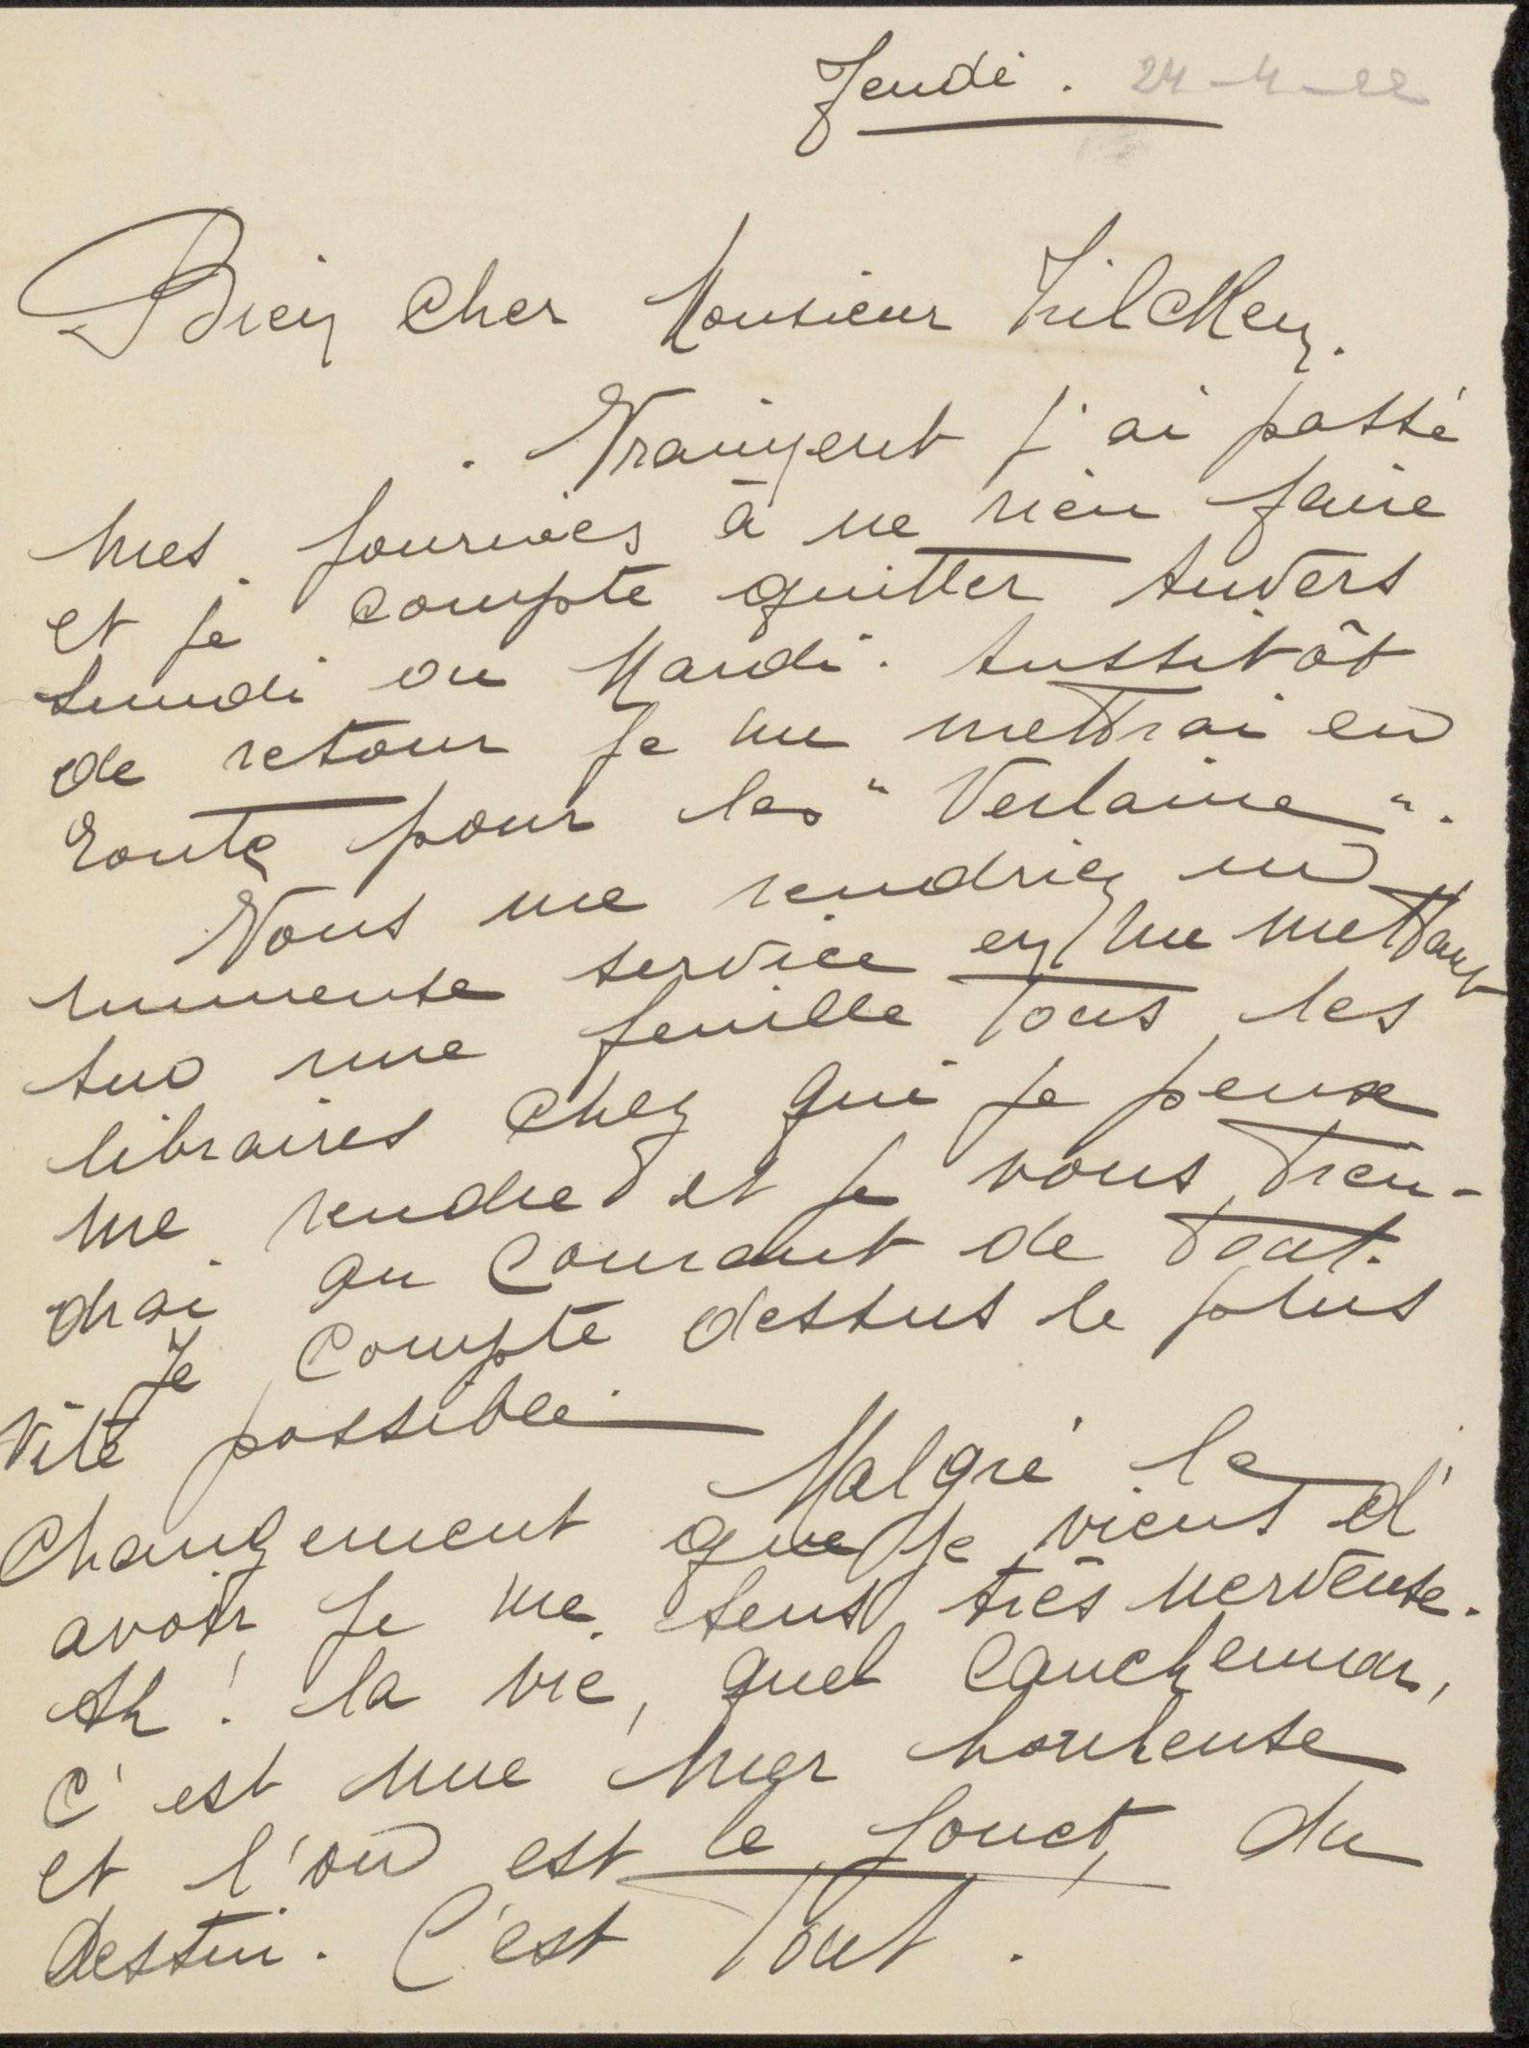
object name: letter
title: Brief aan Philip Zilcken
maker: rose imel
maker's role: draughtsman, painter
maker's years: 1901-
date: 1911-1930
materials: ink, paper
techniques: pen, writing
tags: paris, paul verlaine, the hague, philip zilcken, drawing, antwerp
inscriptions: collector's mark: ‘RPK’